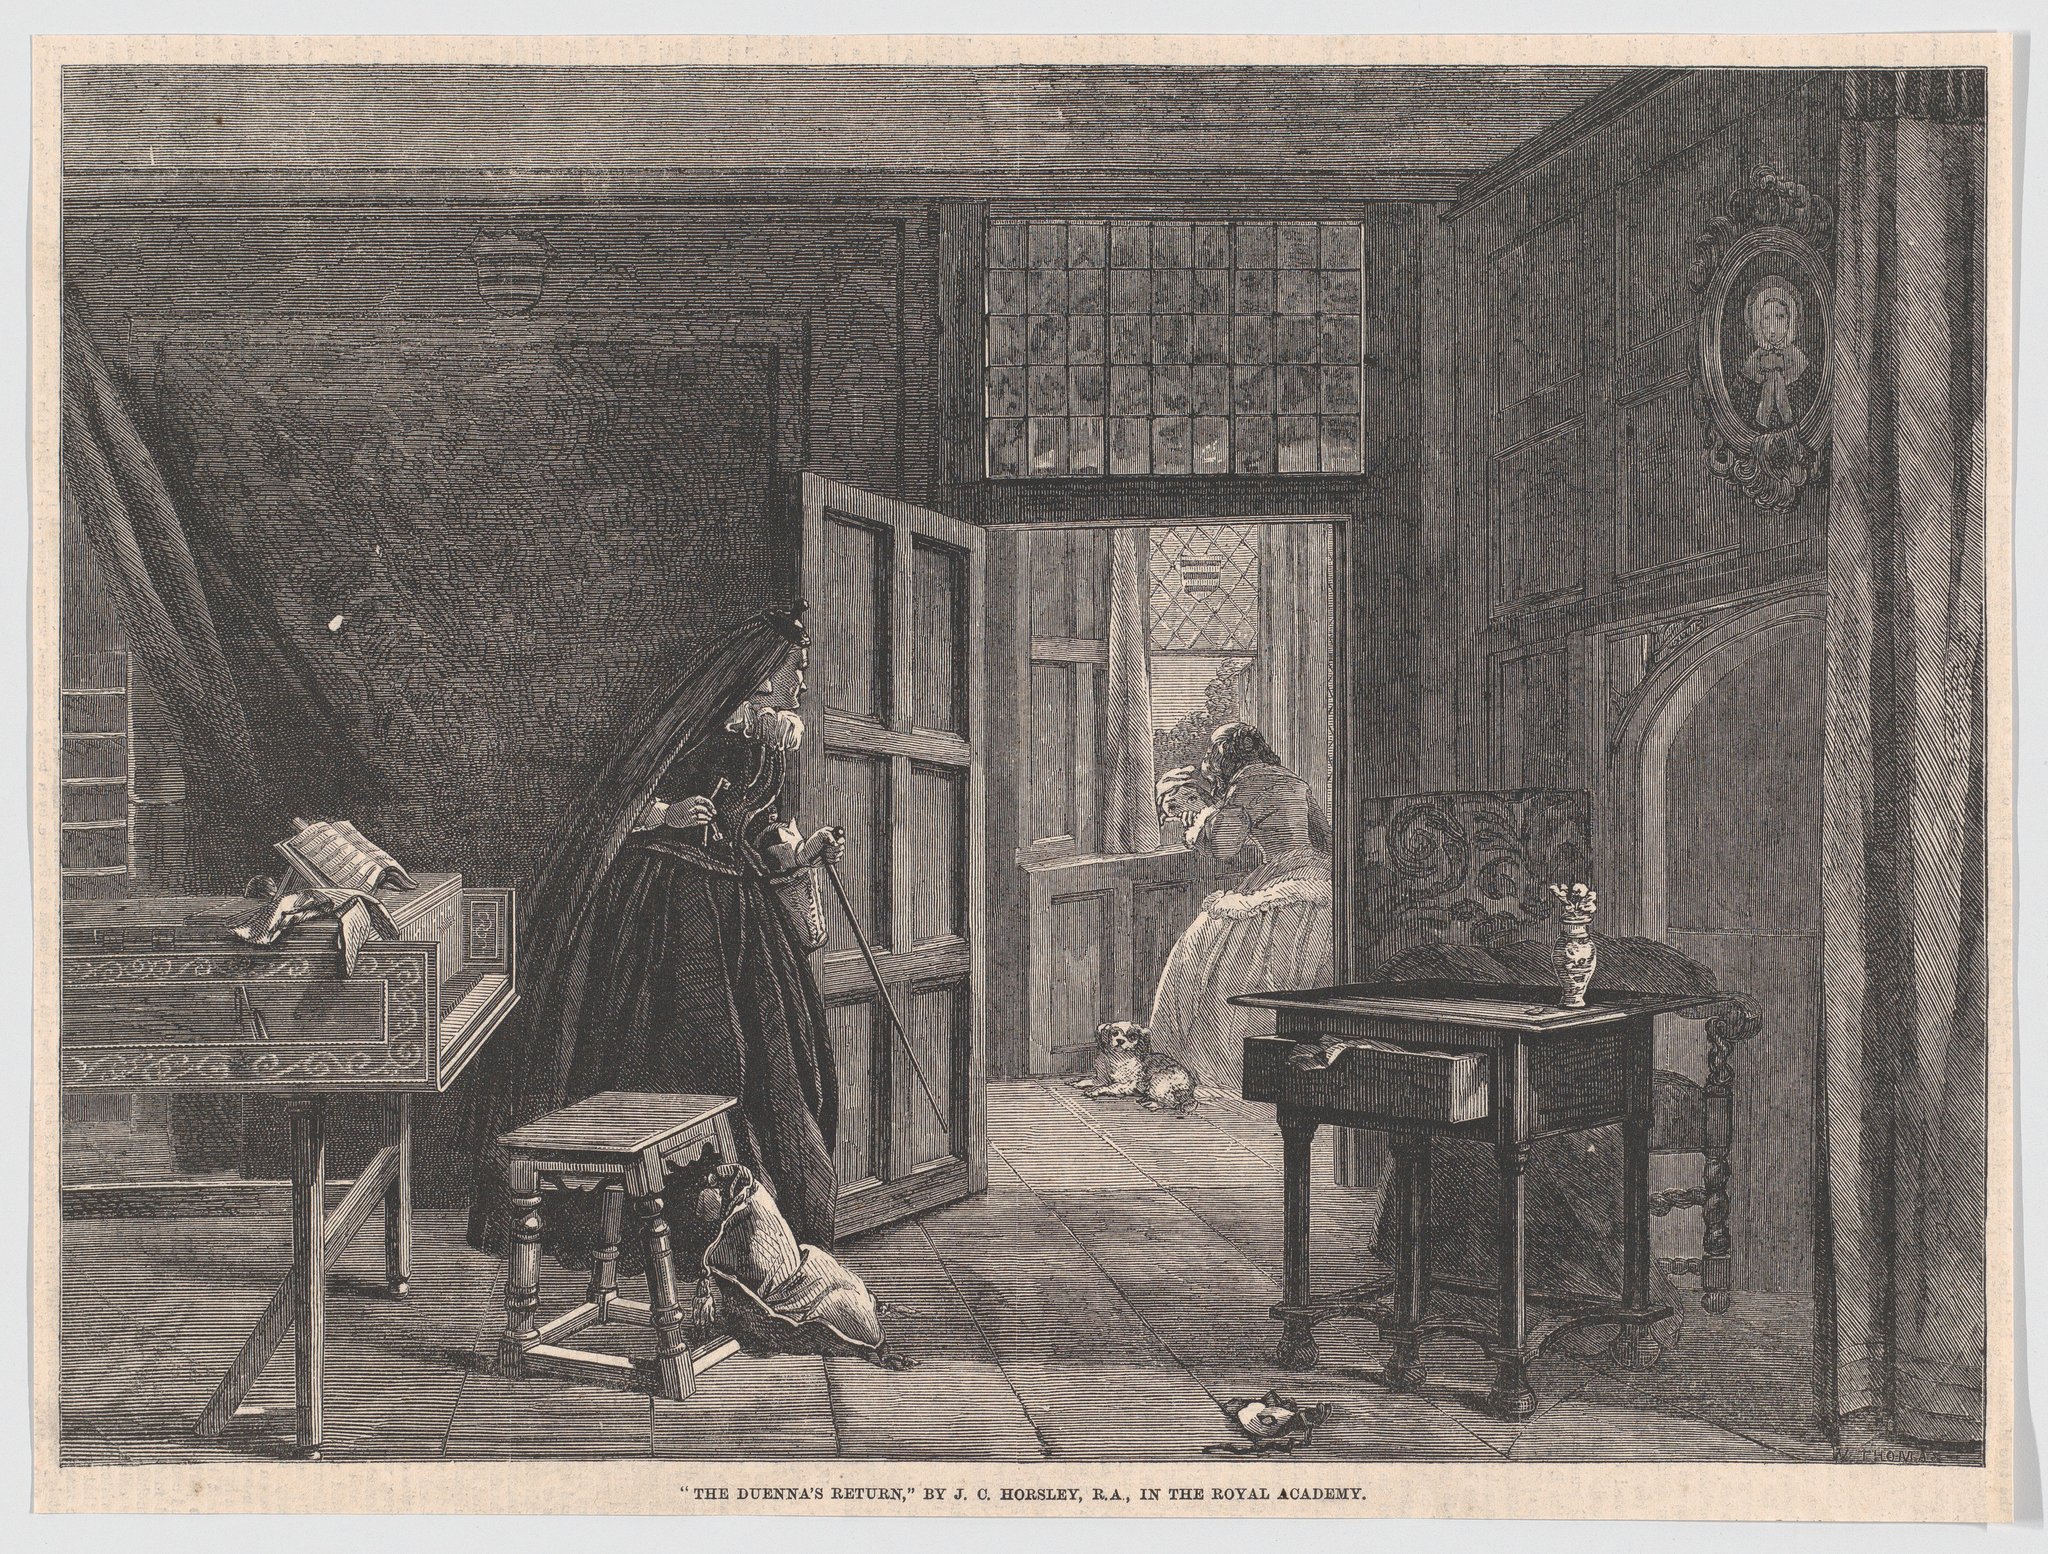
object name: print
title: The Duenna's Return, from "Illustrated London News"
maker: william luson thomas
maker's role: engraver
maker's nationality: british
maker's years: 1830-1900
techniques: engraving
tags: musical instruments,interiors,women,dogs